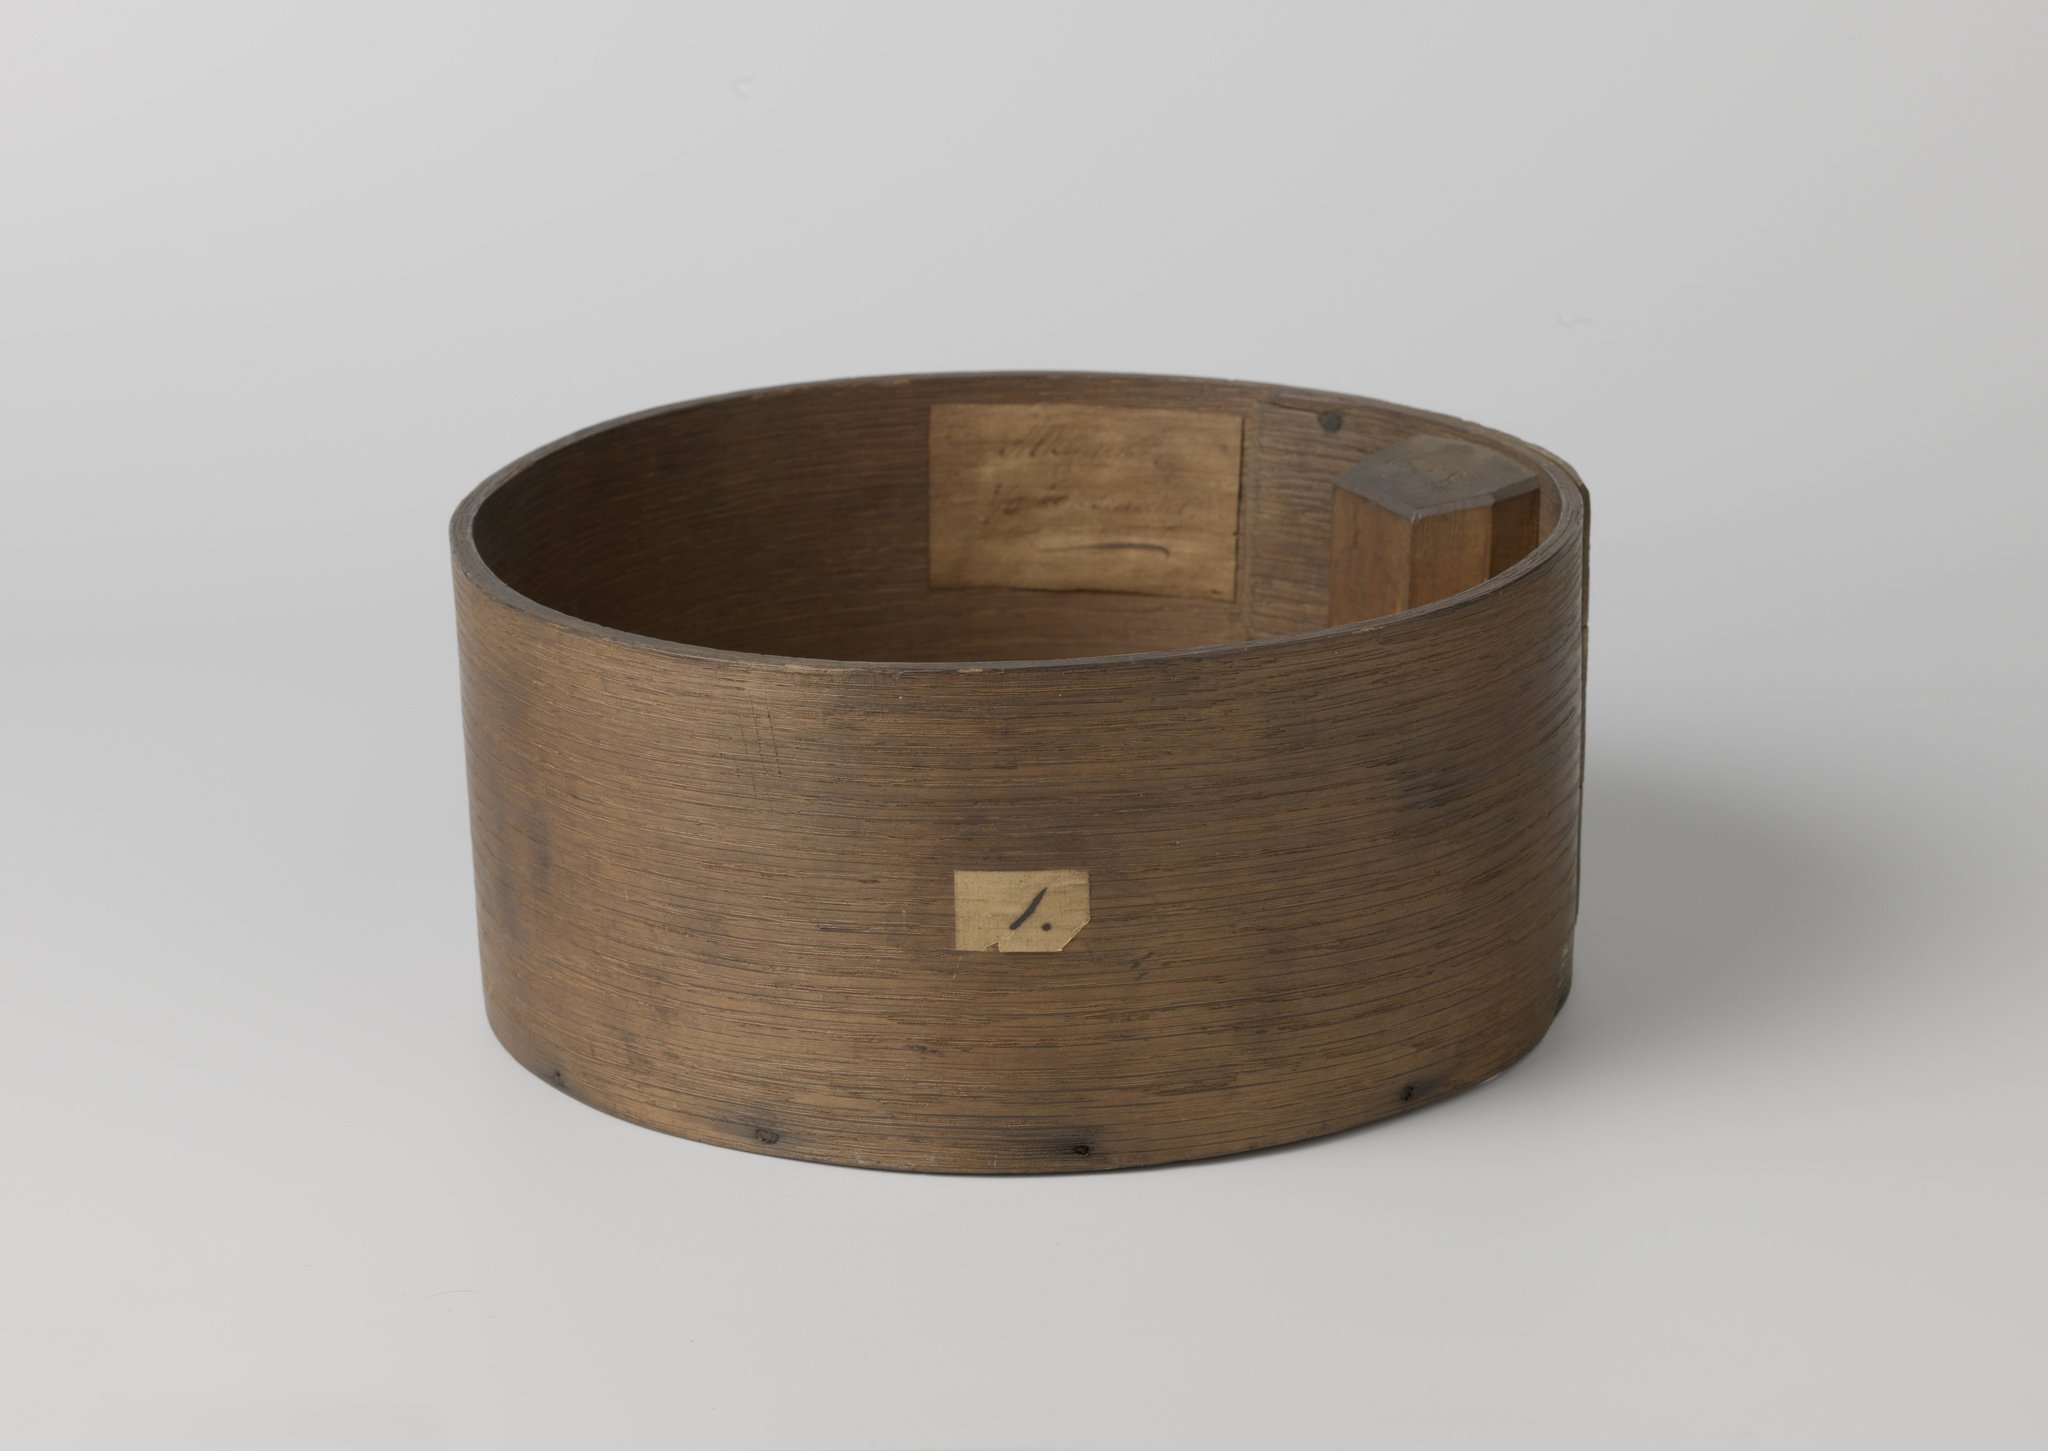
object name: inhoudsmaat droge waren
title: 1/8 Zaksmaat uit Alkmaar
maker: Anonymous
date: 1800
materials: wood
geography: alkmaar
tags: alkmaar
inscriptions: title: ‘Alkmaar / 1/8 zaksmaat’, : ‘1800’, number: ‘1’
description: Spanen inhoudsmaat van 1/8 zaksmaat, v.z.v. merk en etiketten.